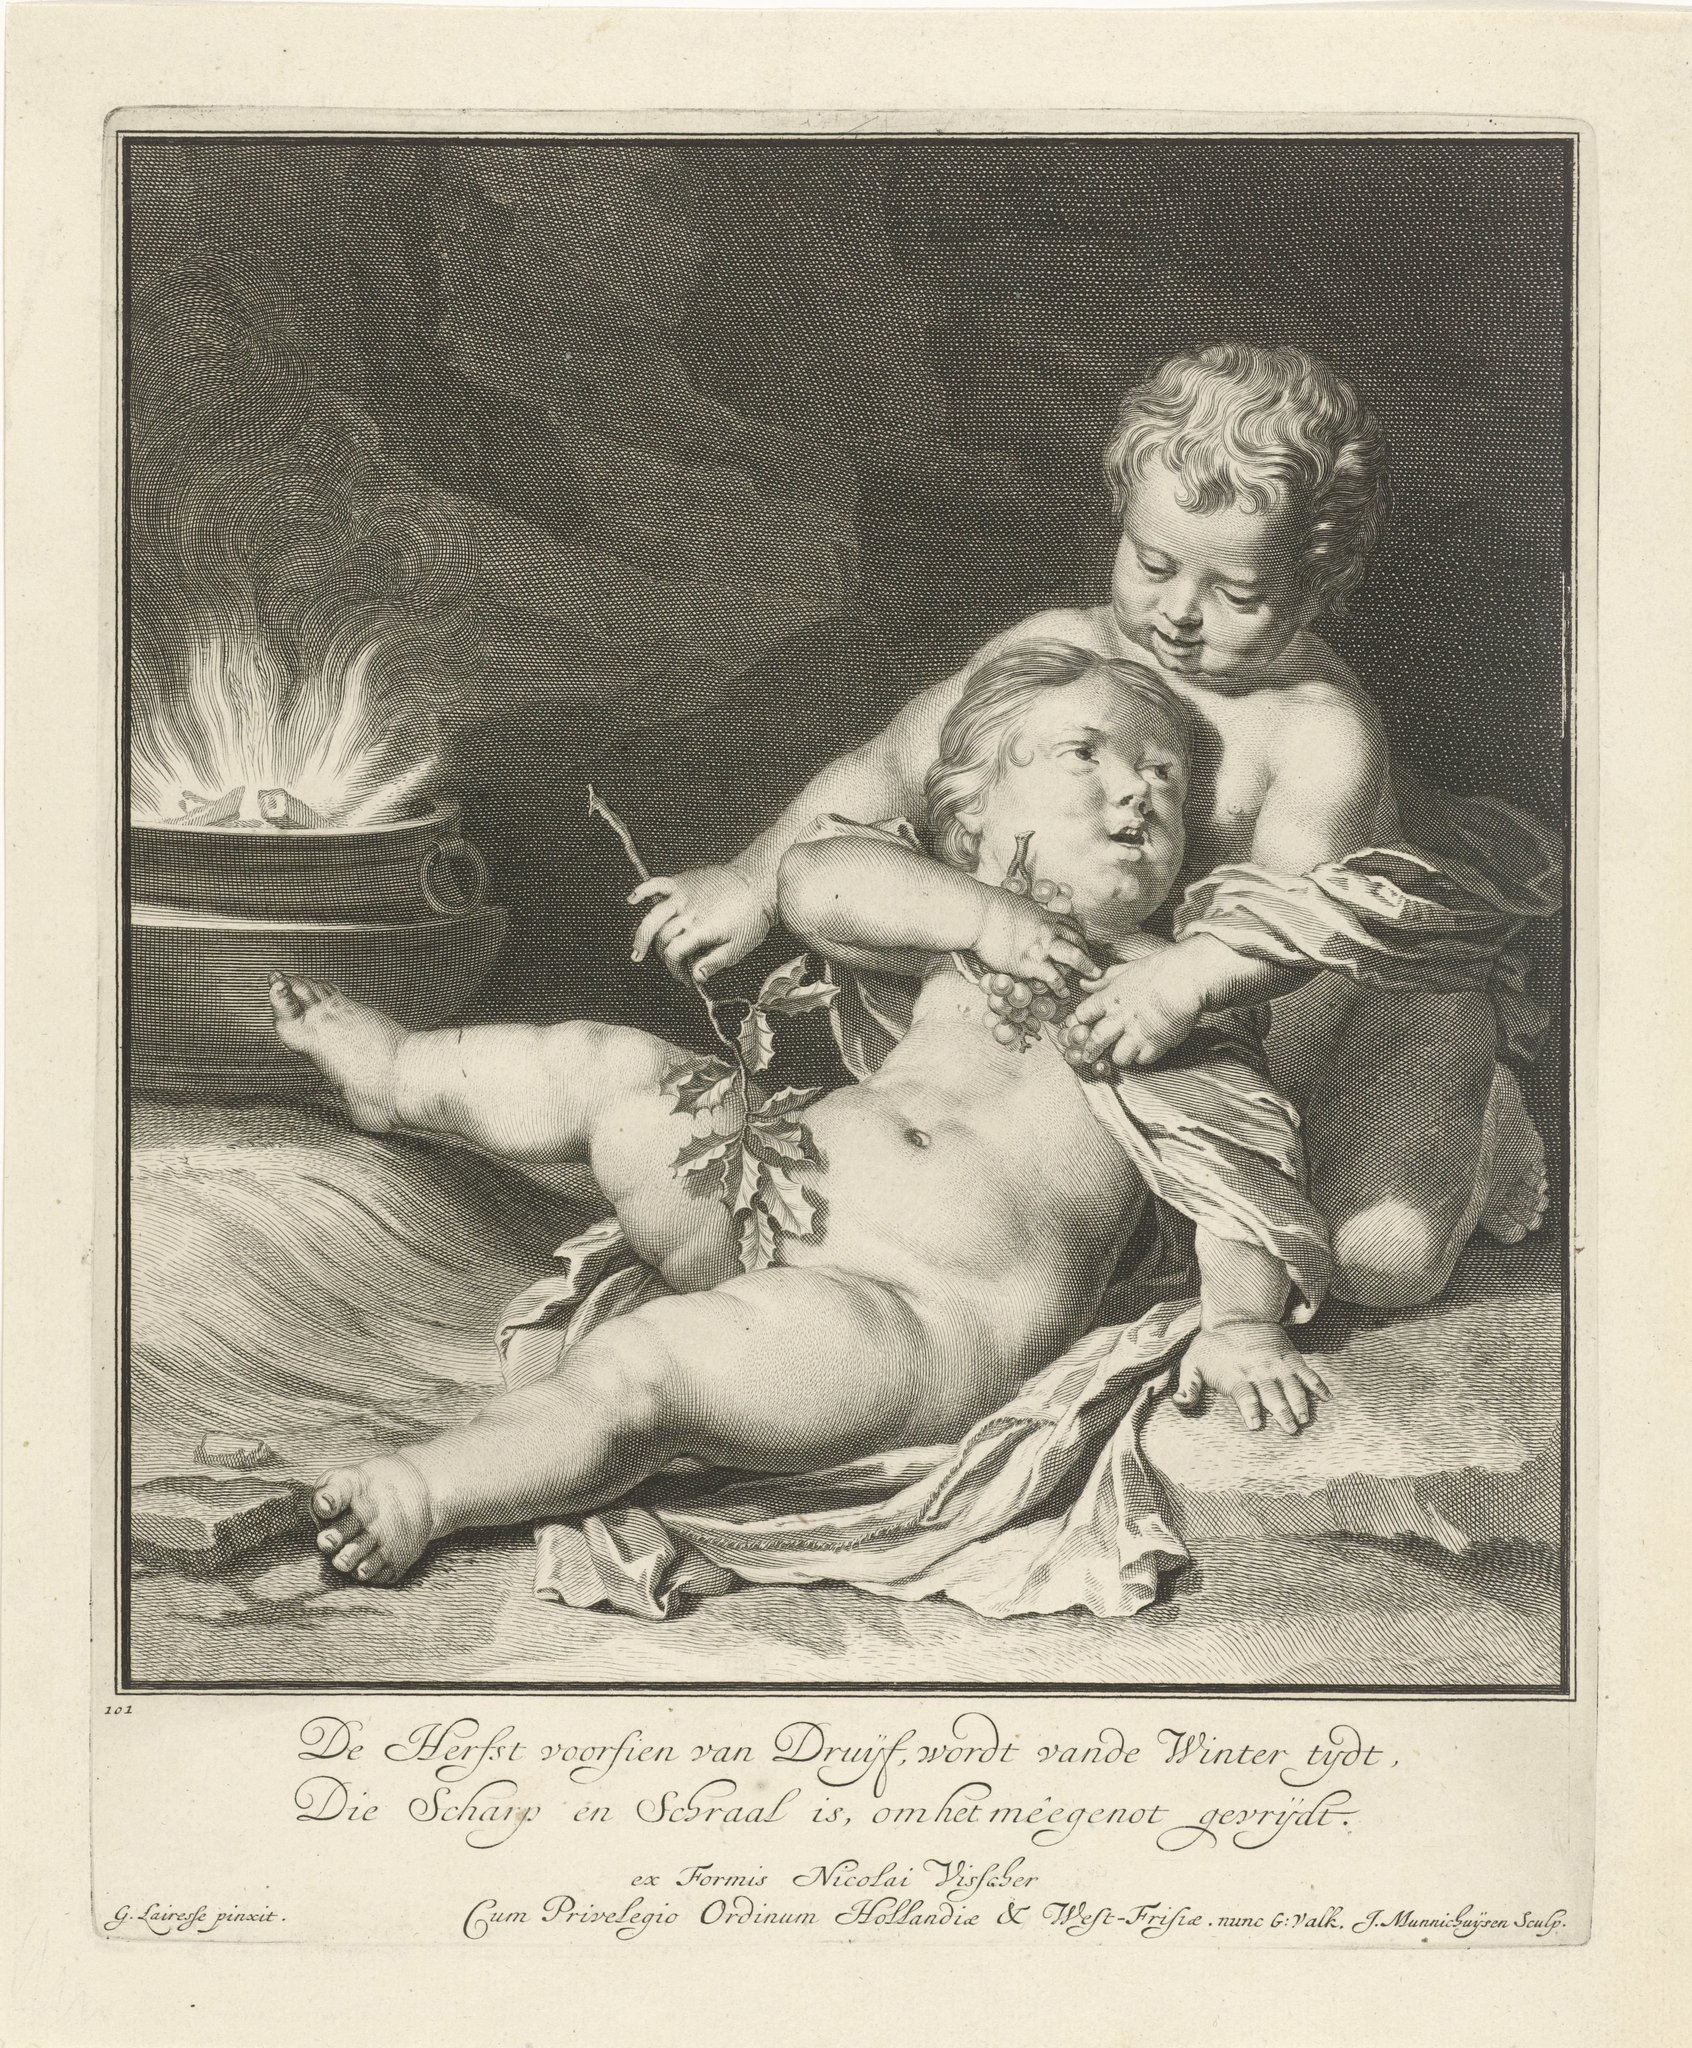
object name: print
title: Twee kinderen met druiventros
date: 1664-1721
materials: paper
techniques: engraving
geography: amsterdam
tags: children's bacchanal, warming oneself at a fire (or hearth, stove, fire-pan, brazier), cupids: 'amores', 'amoretti', 'putti', bunch of grapes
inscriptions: collector's mark: Lugt 2228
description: Twee naakte kinderen bij een vuurpot. Het ene kind probeert druiven van de druiventros van de ander te ontfutselen. Onder de voorstelling een tweeregelig vers in het Nederlands, waarin wordt aangegeven dat druiven in de wintertijd fel begeerd worden. Linksonder genummerd: 101.